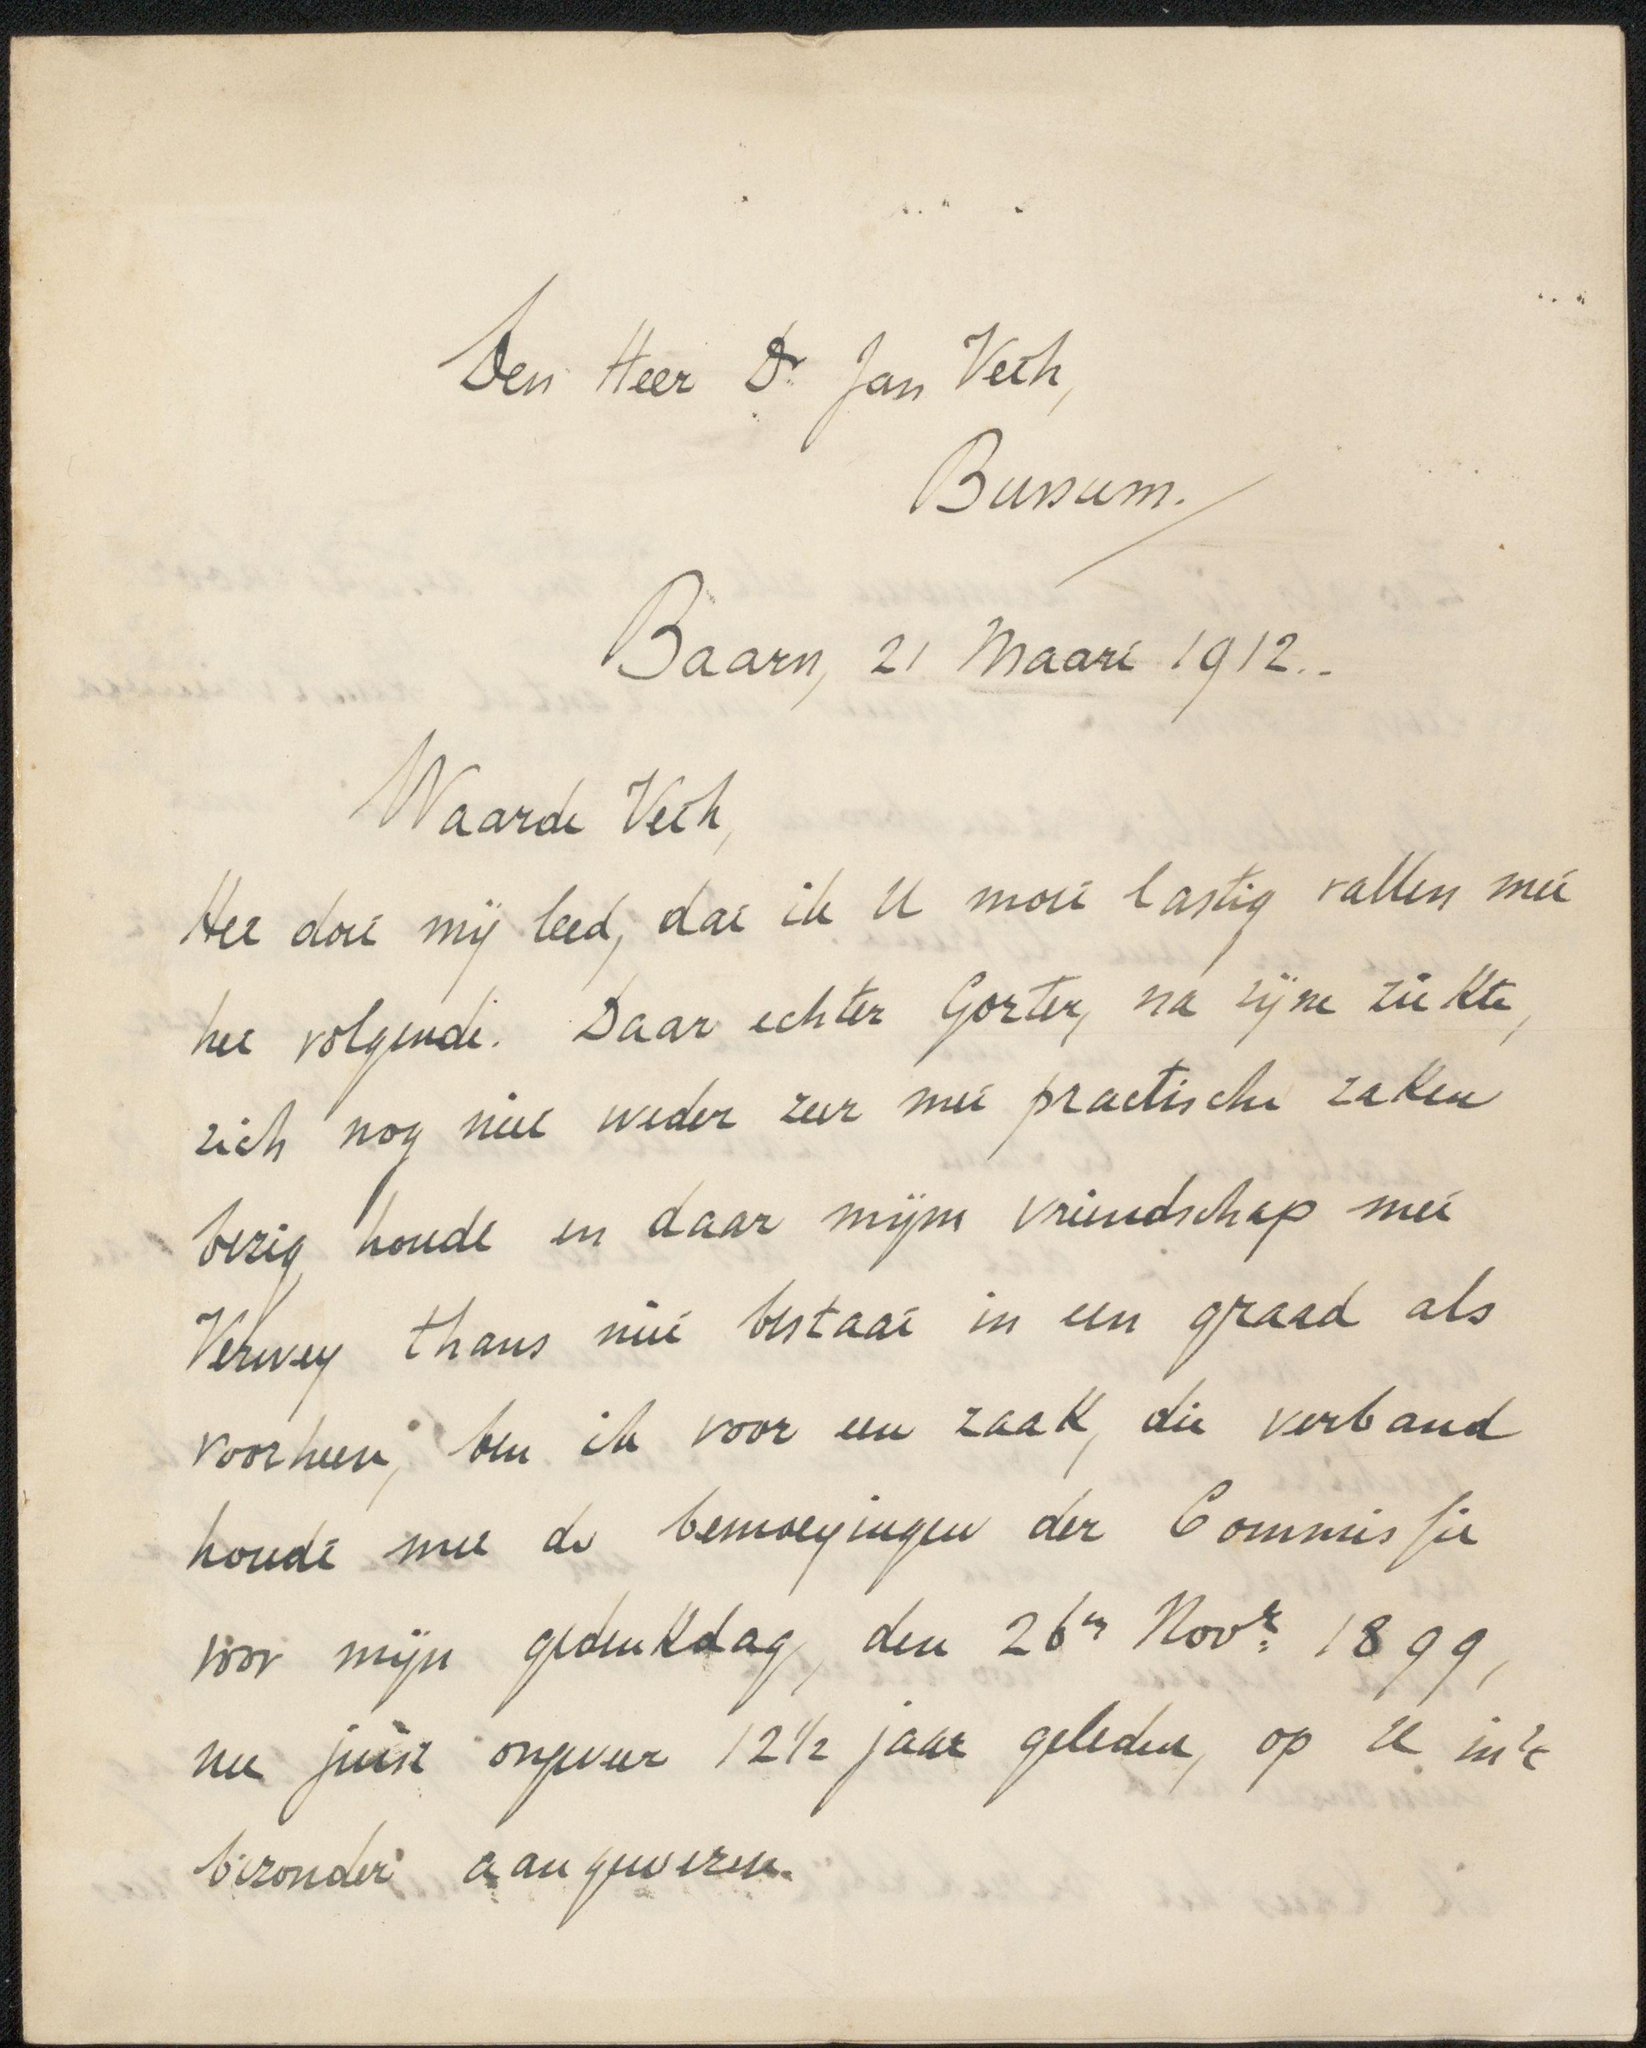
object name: letter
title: Brieven aan Jan Veth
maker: karel johan lodewijk alberdingk thijm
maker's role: criticus, prozaschrijver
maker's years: 1864-1952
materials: ink, paper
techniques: pen, writing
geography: baarn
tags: the hague, painter, print maker, draughtsman, jozef israëls, dordrecht, amsterdam, designer, jan veth, herman gorter, albert verwey, money, london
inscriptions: collector's mark: ‘RPK’, watermark